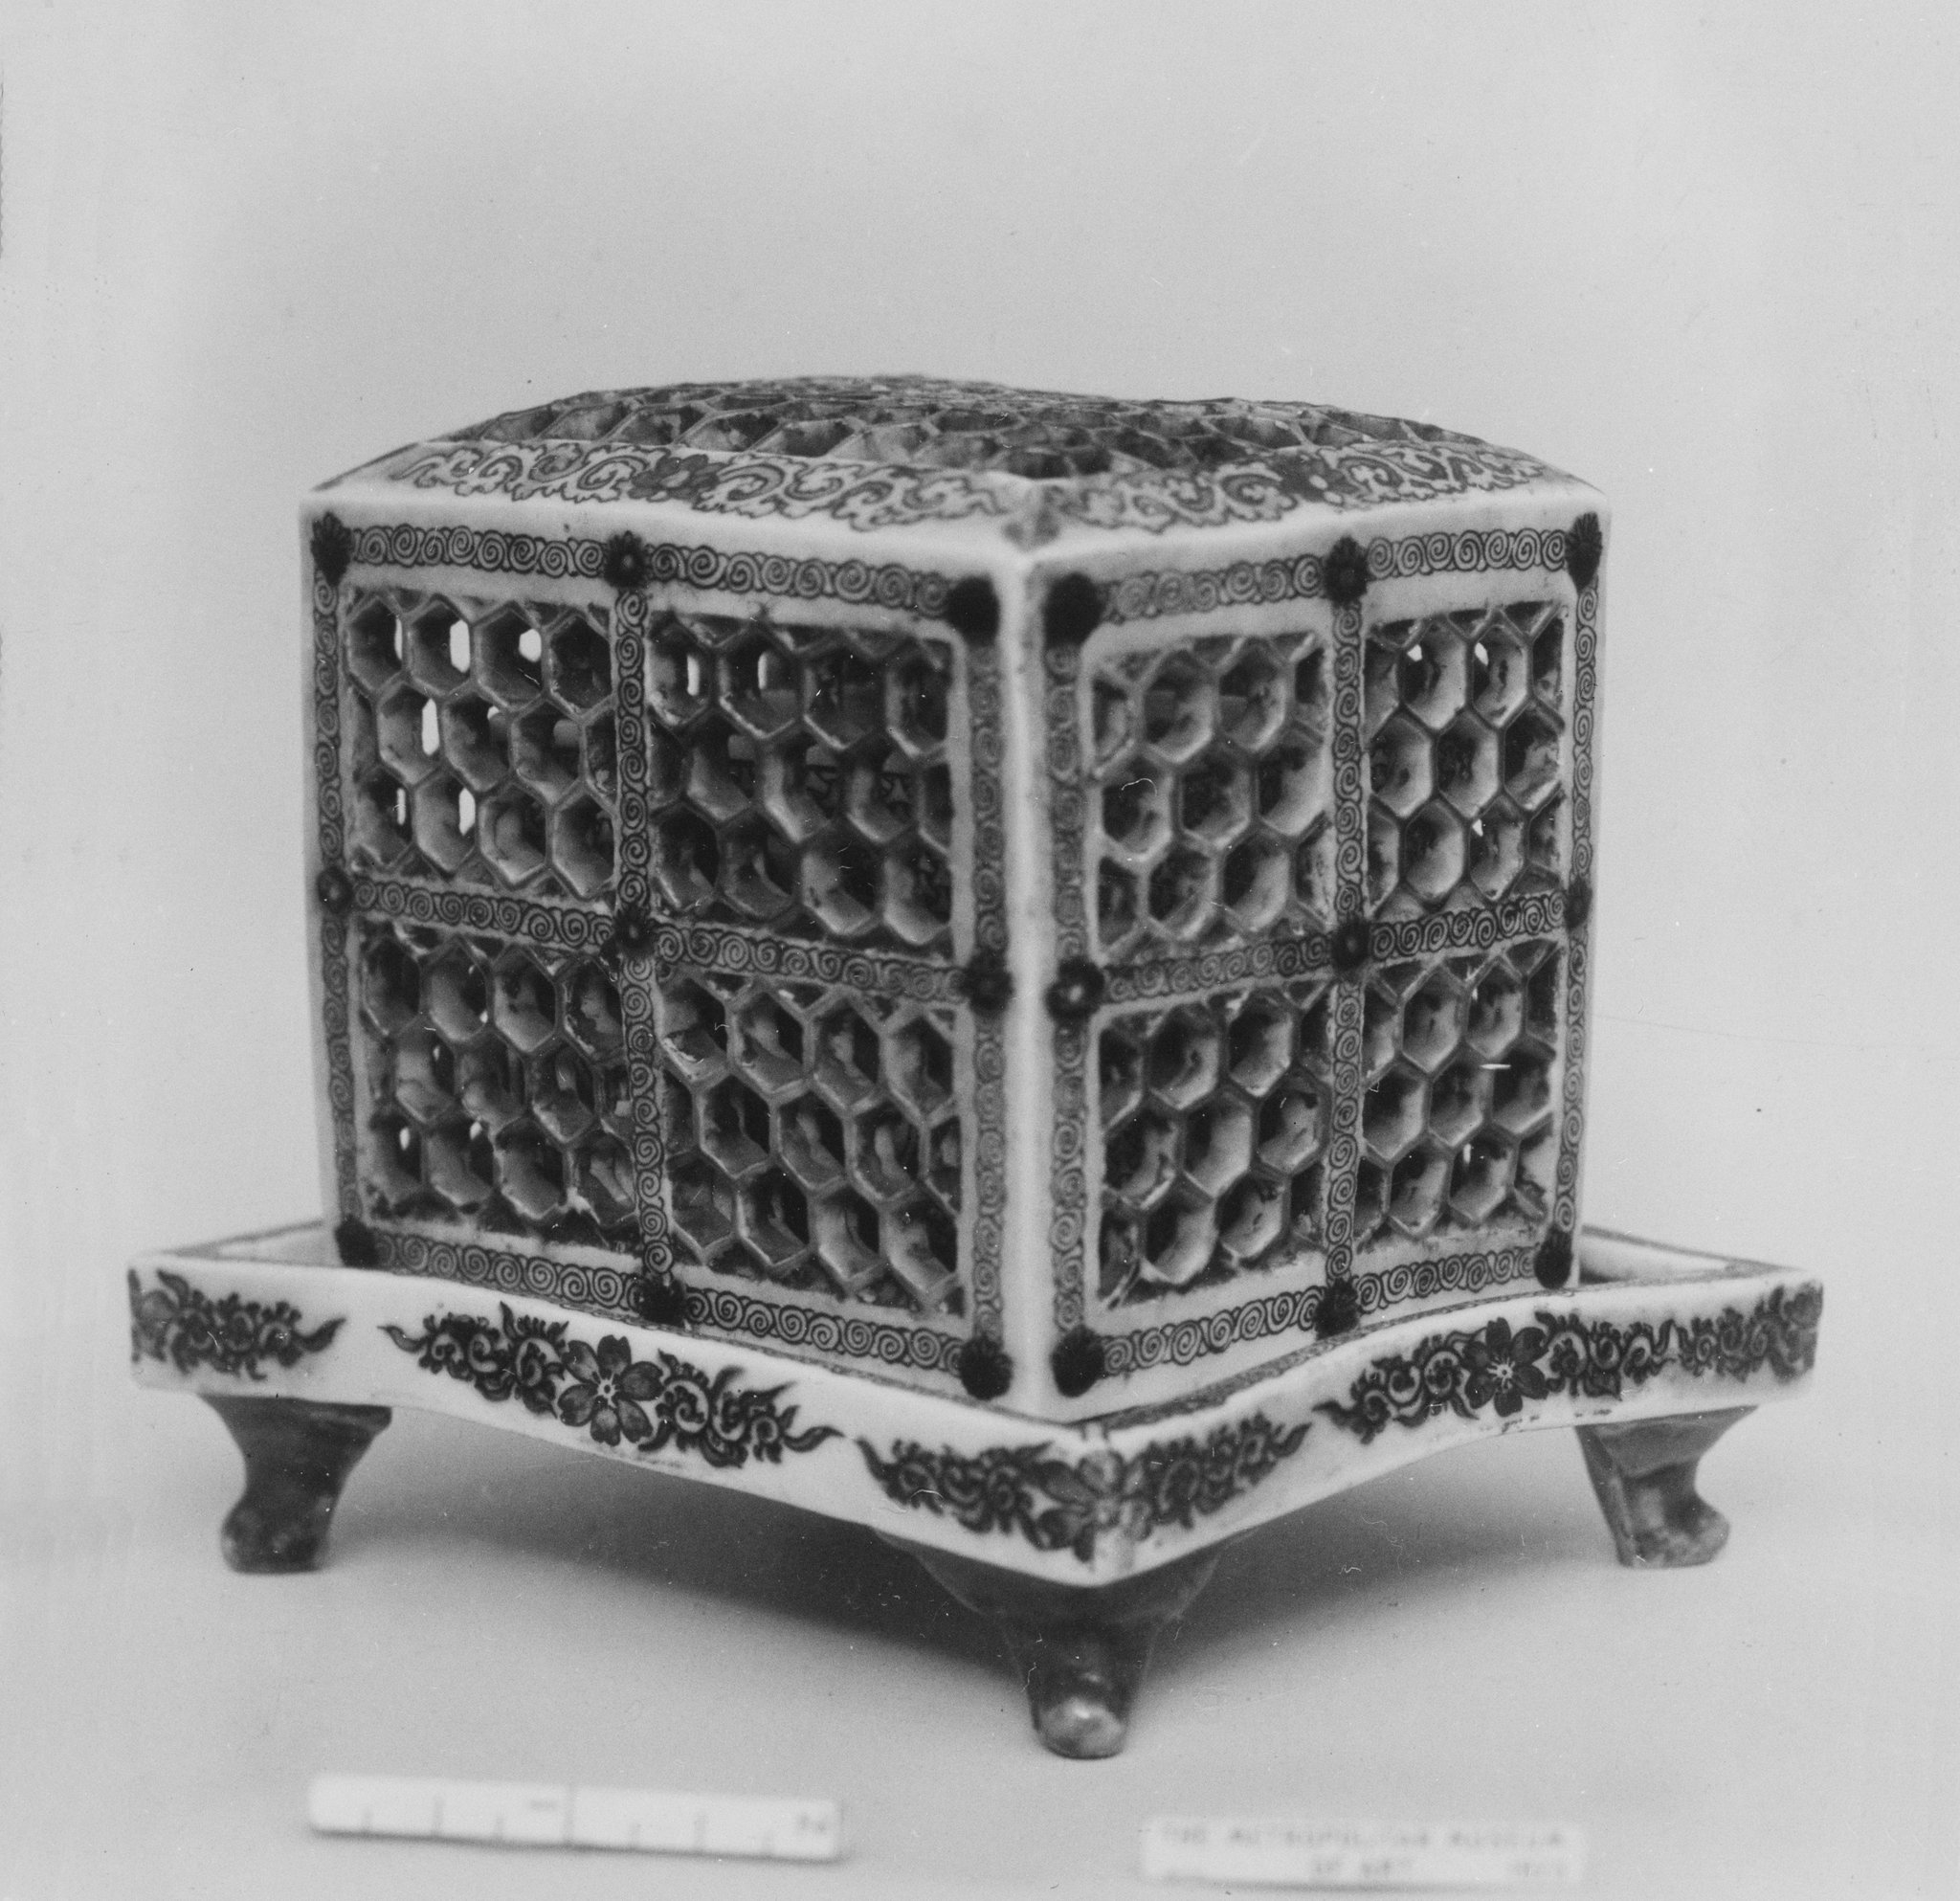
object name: censer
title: Censer with Pierced Design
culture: japanese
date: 1820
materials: enamel, porcelain